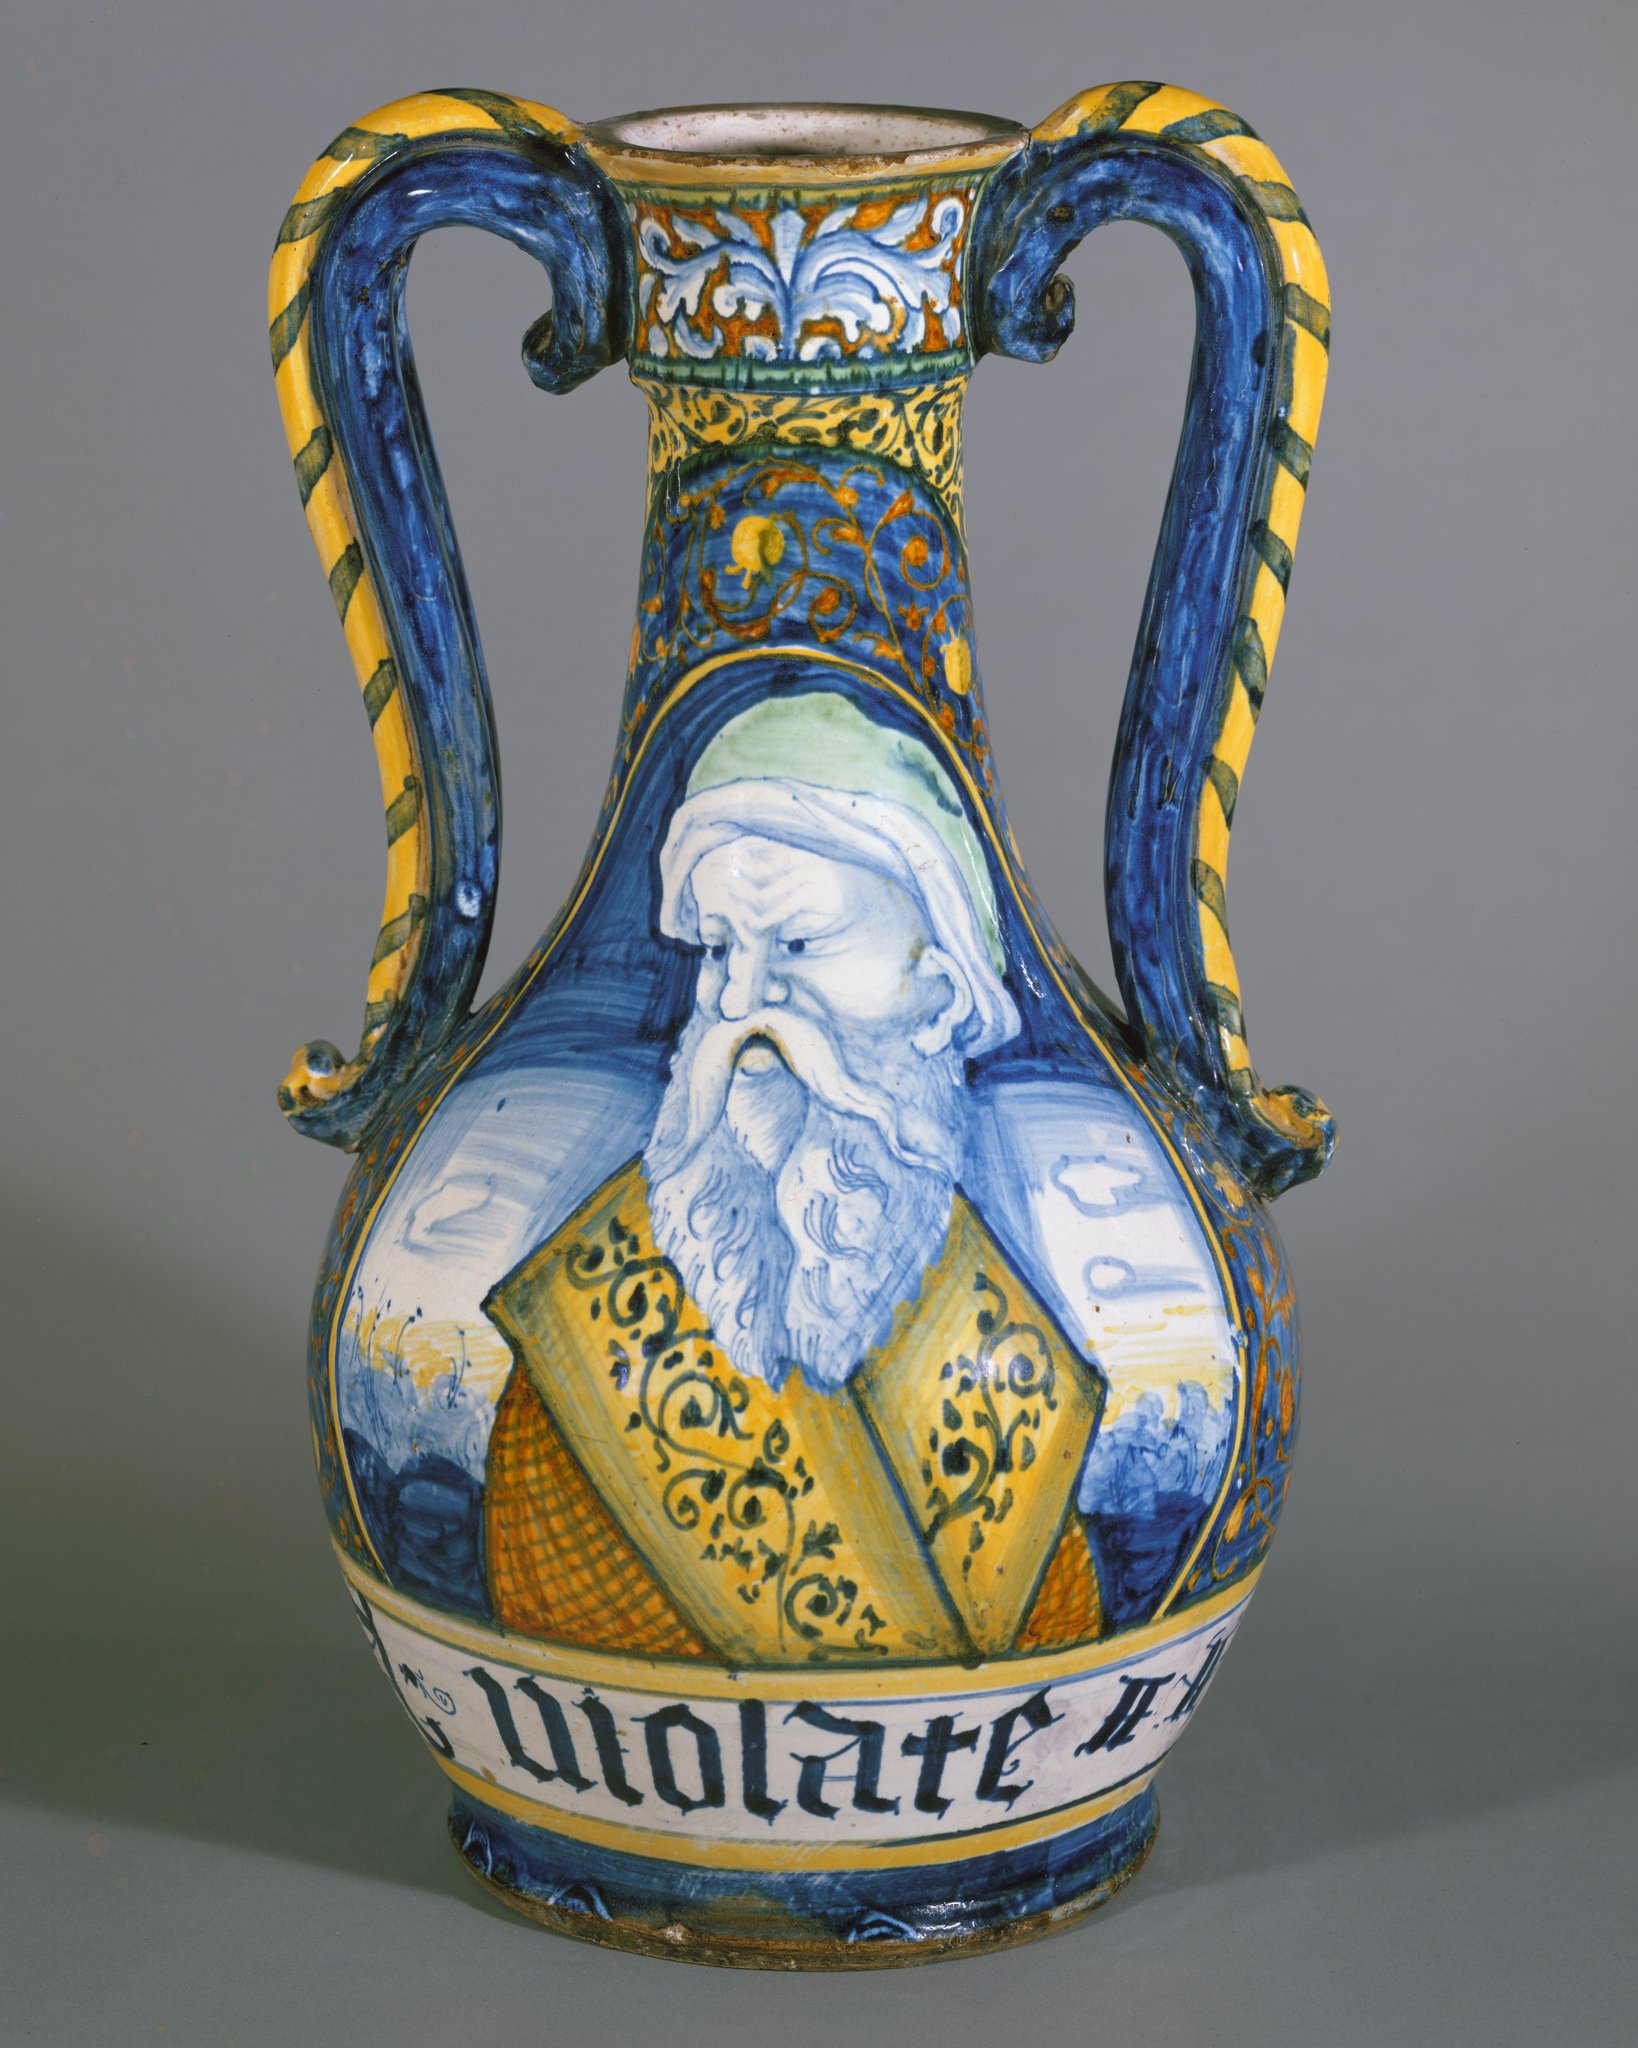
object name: apothecary vase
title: Apothecary vase (vaso da farmacia)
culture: italian, castelli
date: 1520-1530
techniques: maiolica, glazing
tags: men